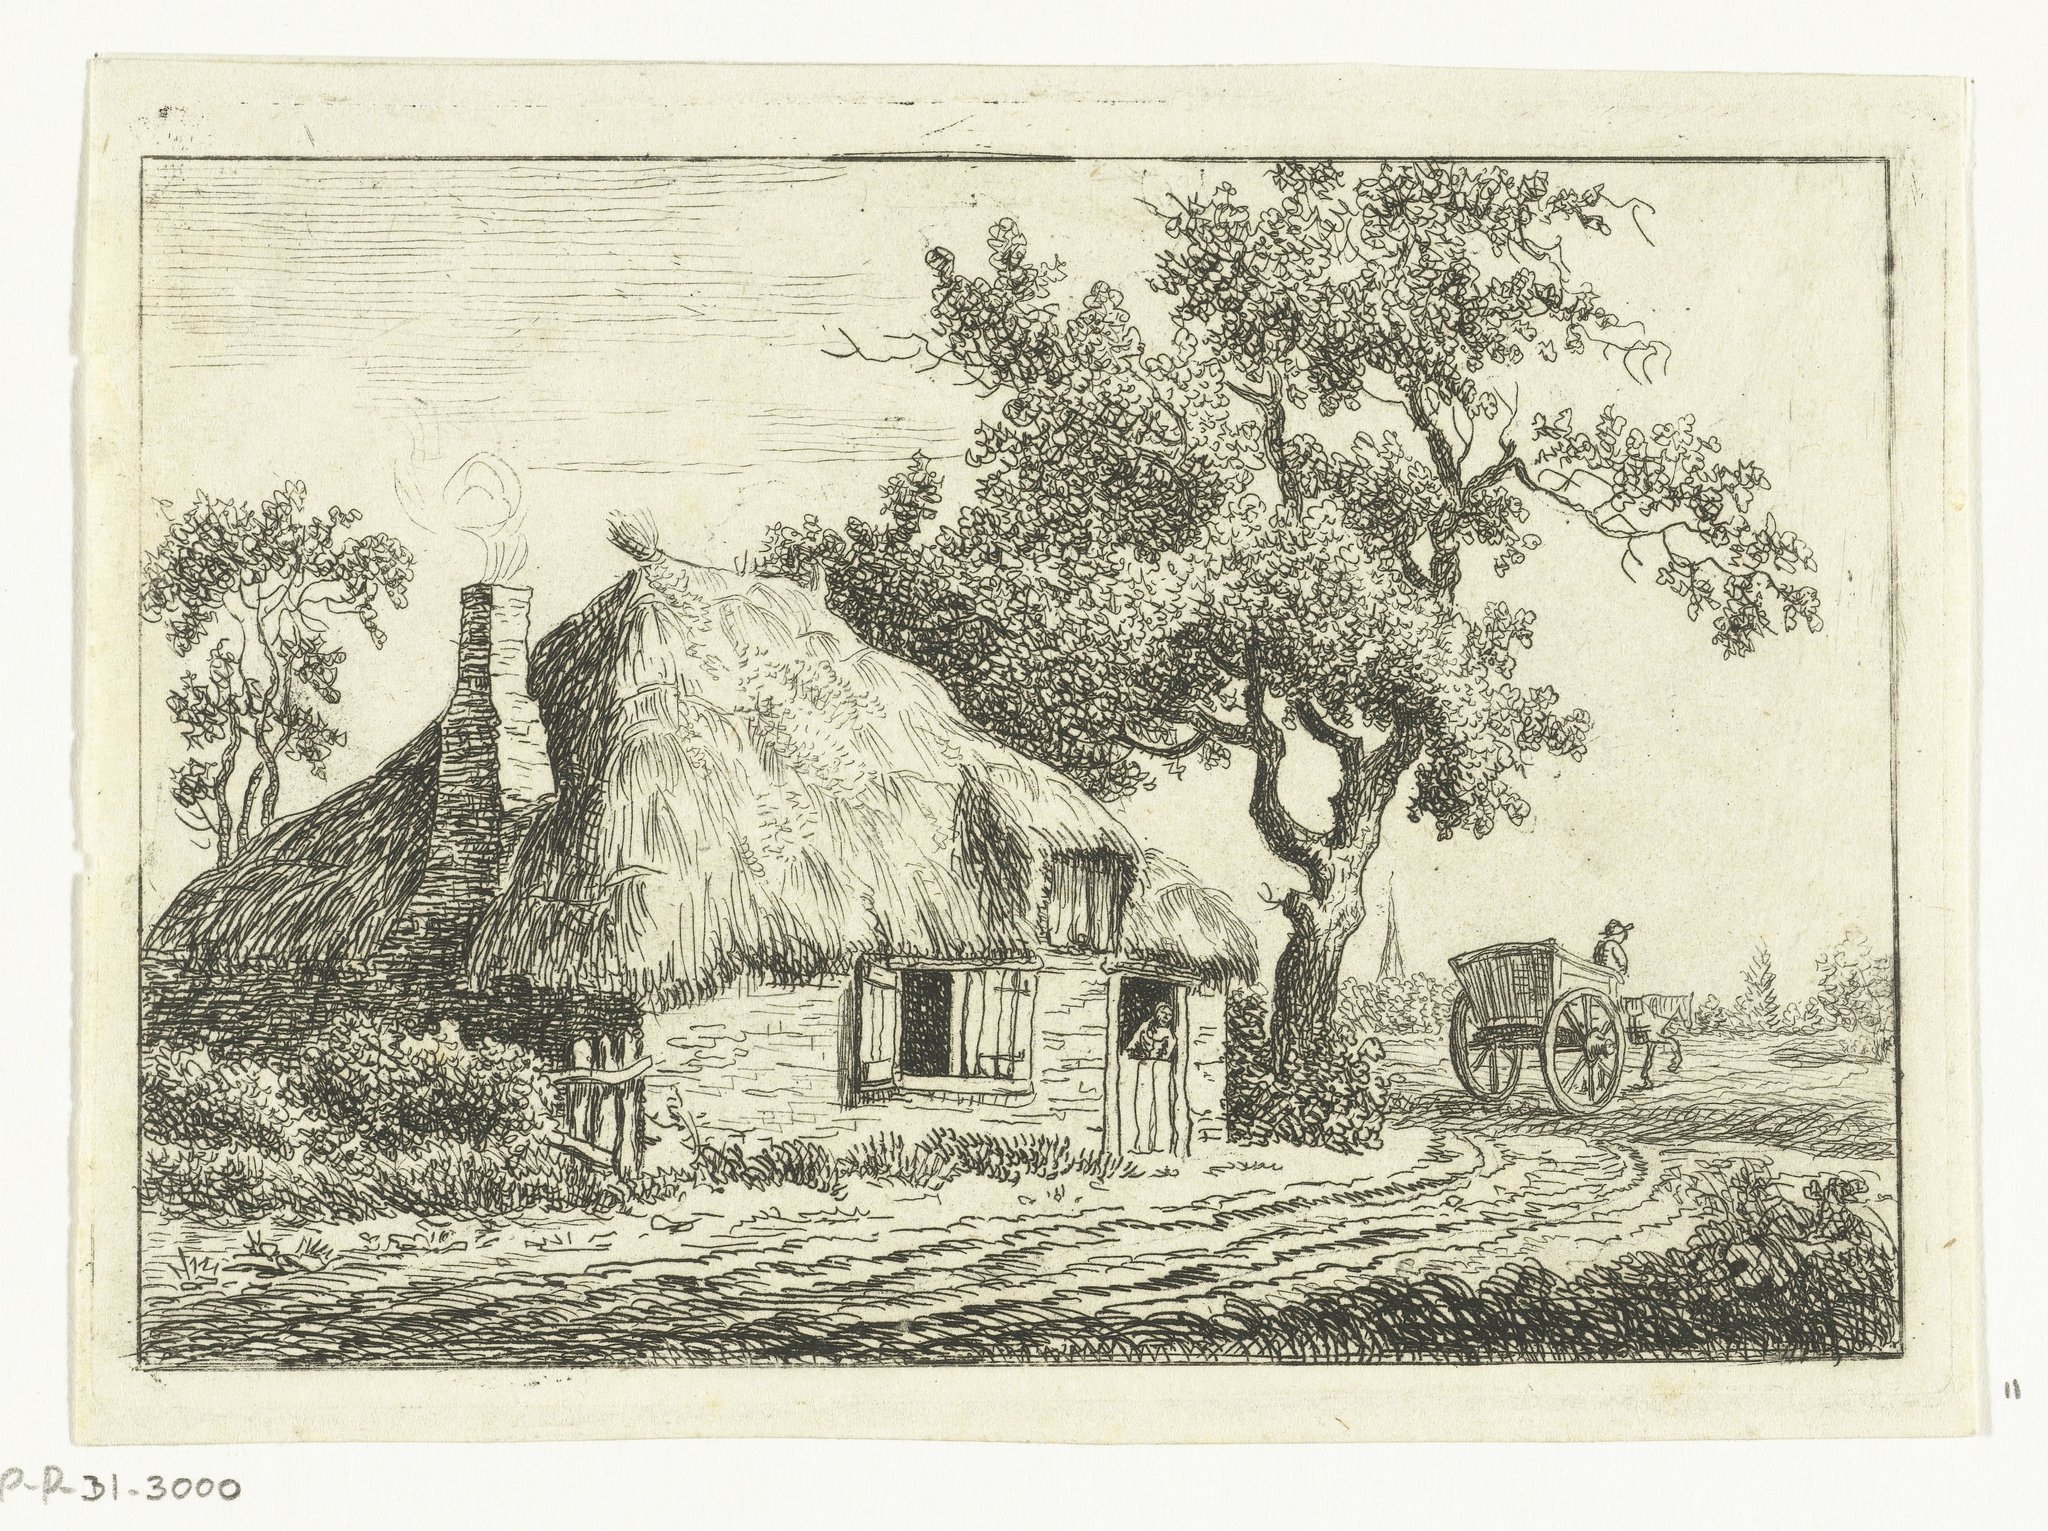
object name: print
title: Paard en wagen bij boerderij buiten Zwolle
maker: anthonie van den bos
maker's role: draughtsman, print maker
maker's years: 1763-1838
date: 1778-1838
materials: paper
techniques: etching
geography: netherlands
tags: farm or solitary house in landscape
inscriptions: collector's mark: Lugt 2228